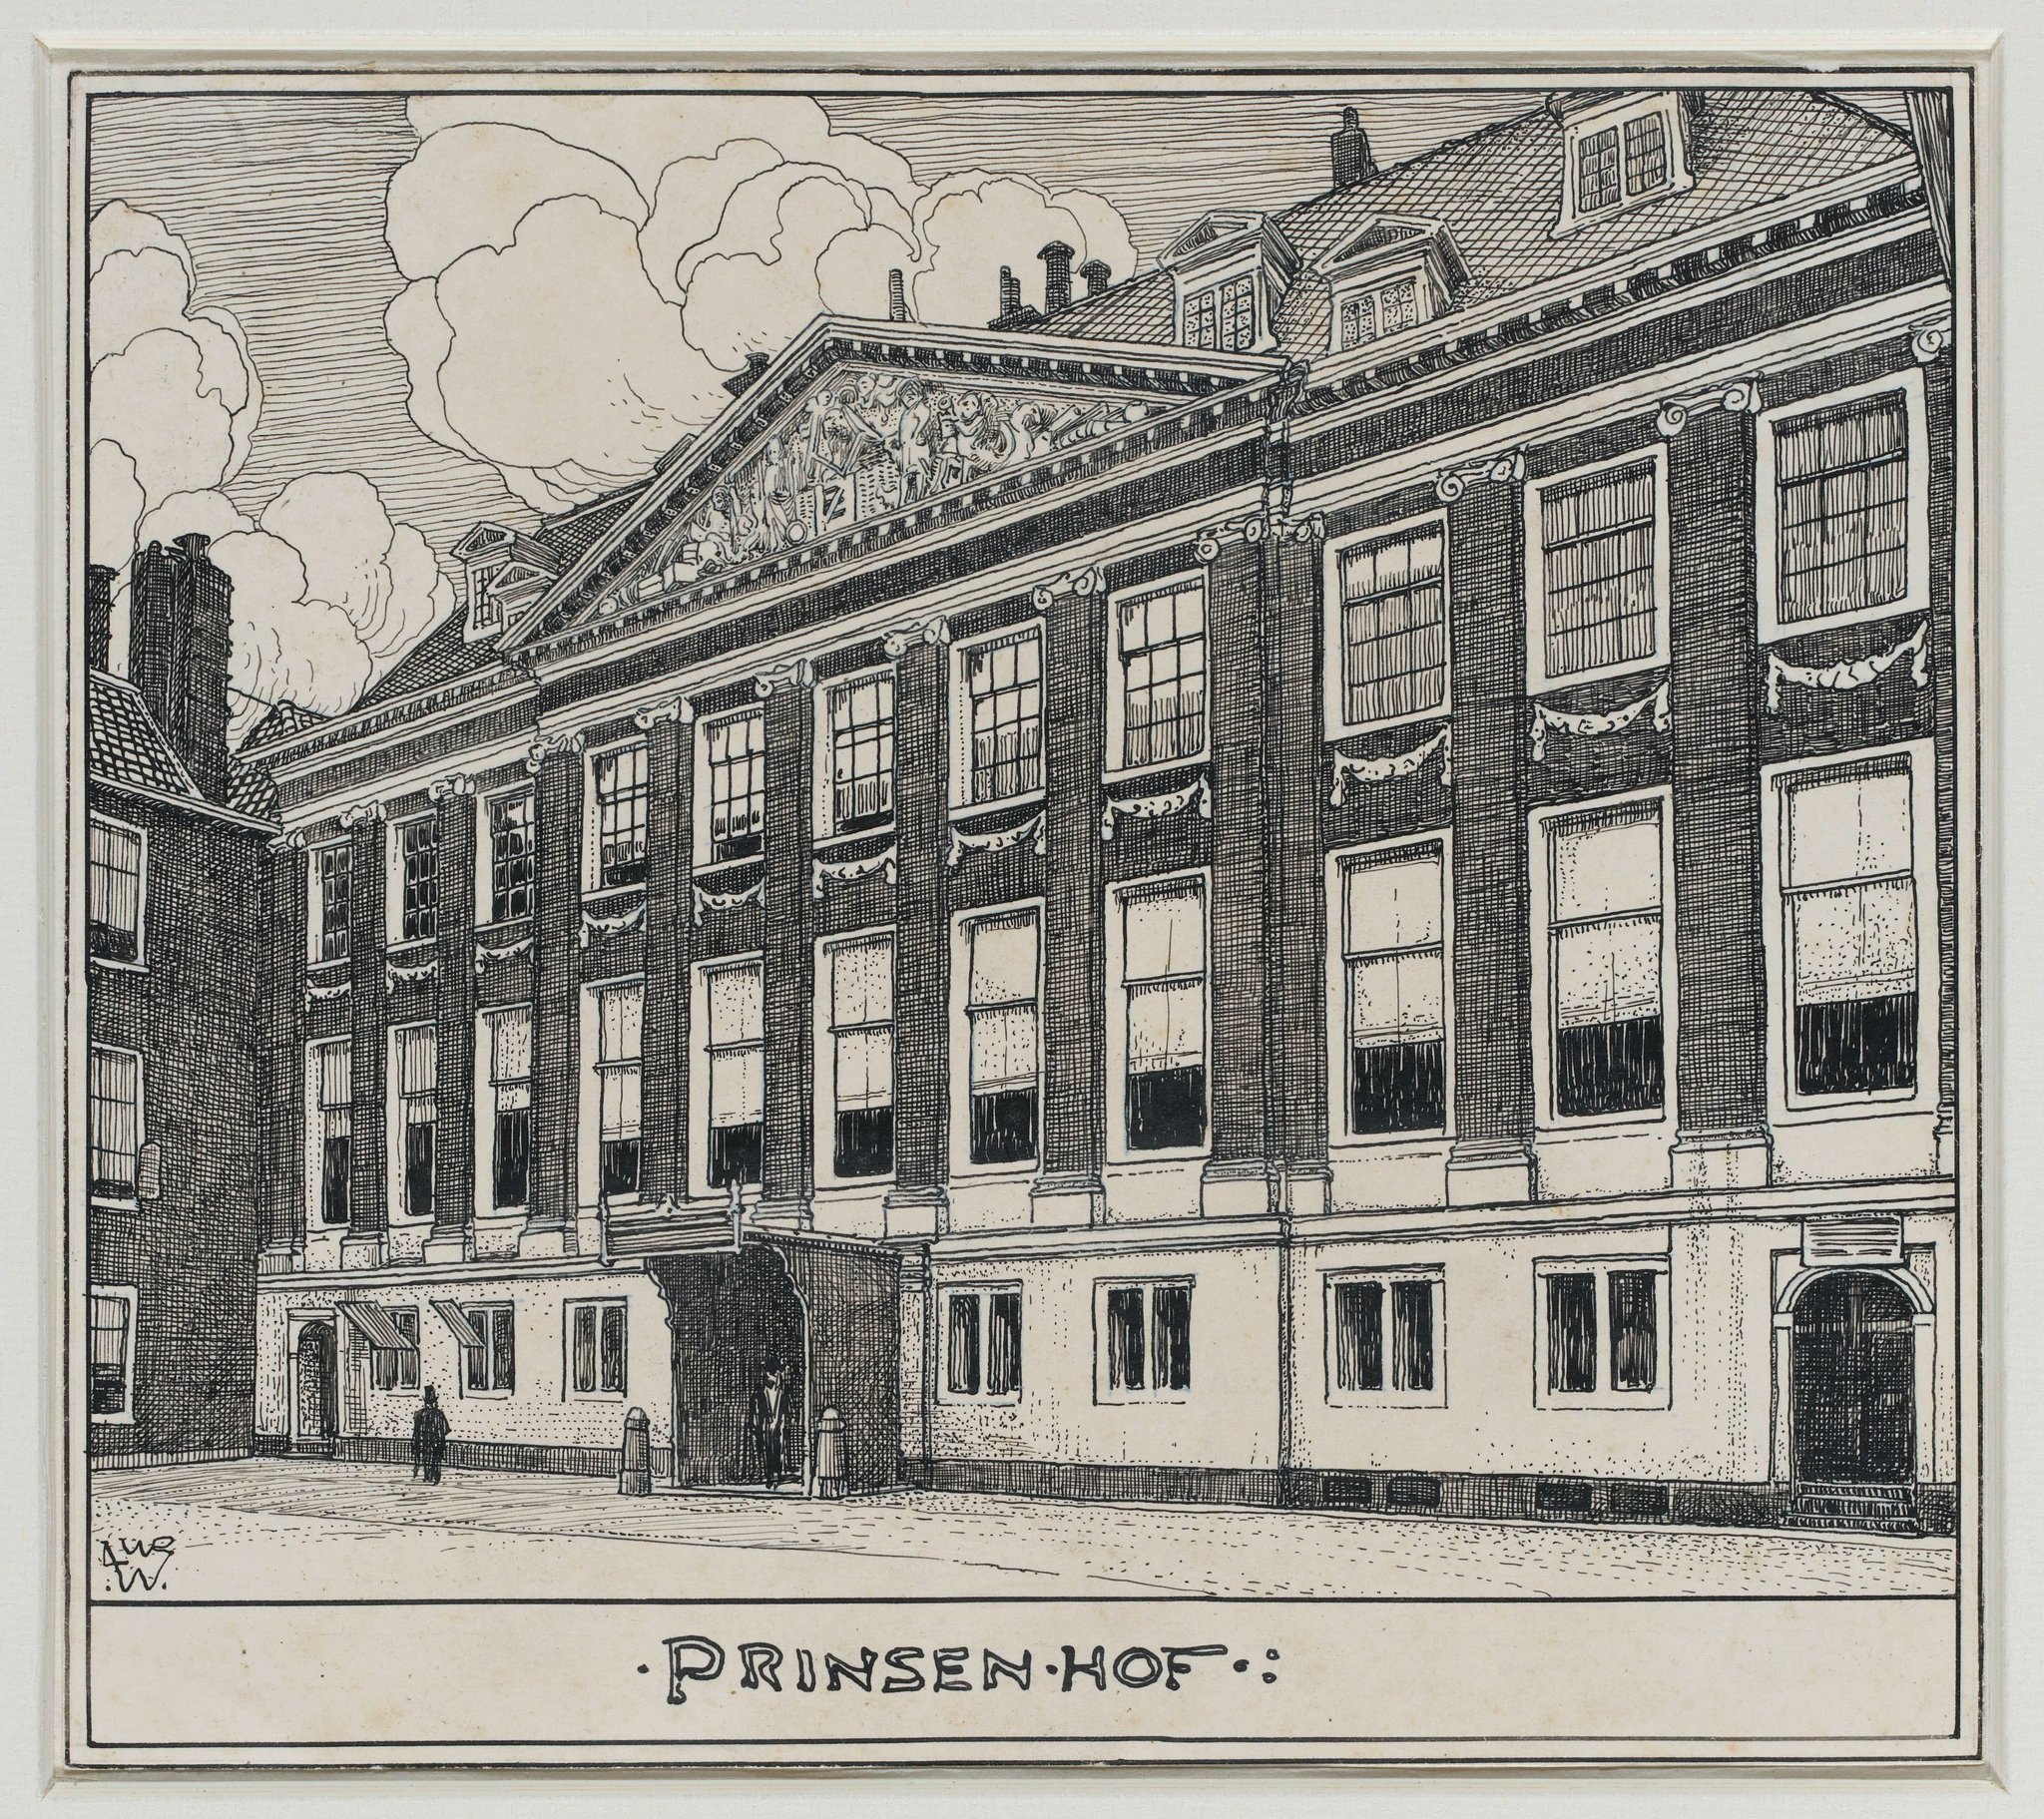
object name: drawing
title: Het Prinsenhof aan de Oudezijds Voorburgwal te Amsterdam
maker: willem wenckebach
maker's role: designer, draughtsman, painter, print maker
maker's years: 1860-1937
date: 1870-1926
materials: ink, paper, pencil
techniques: pen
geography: amsterdam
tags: city-view, and landscape with man-made constructions, street